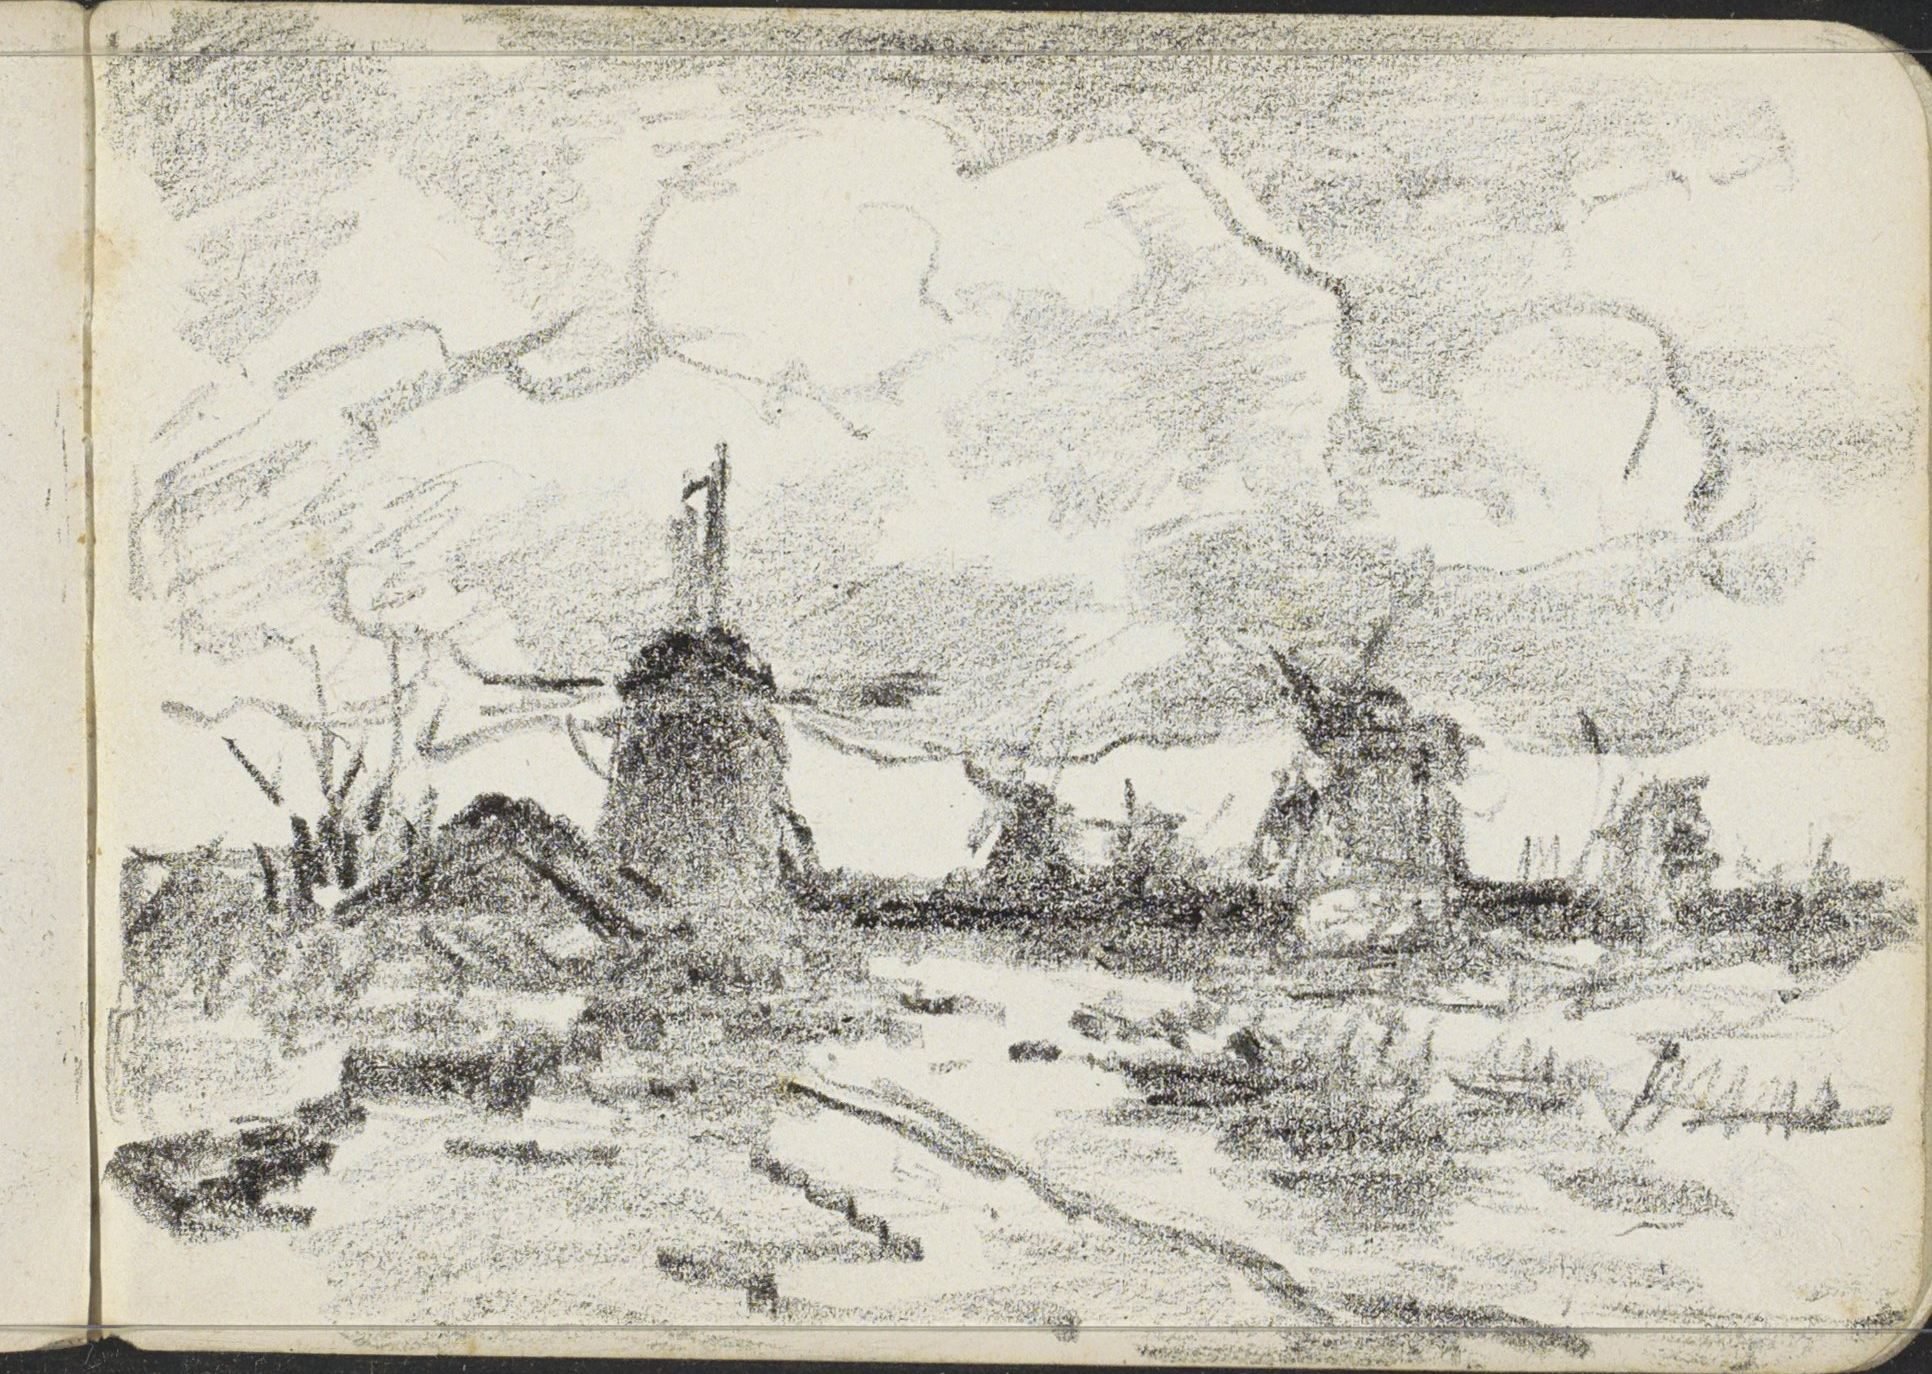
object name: sketchbook leaf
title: Landschap met molens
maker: willem cornelis rip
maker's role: draughtsman, painter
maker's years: 1856-1922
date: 1907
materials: chalk, paper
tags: windmill in landscape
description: Blad 39 recto uit een schetsboek met 41 bladen.